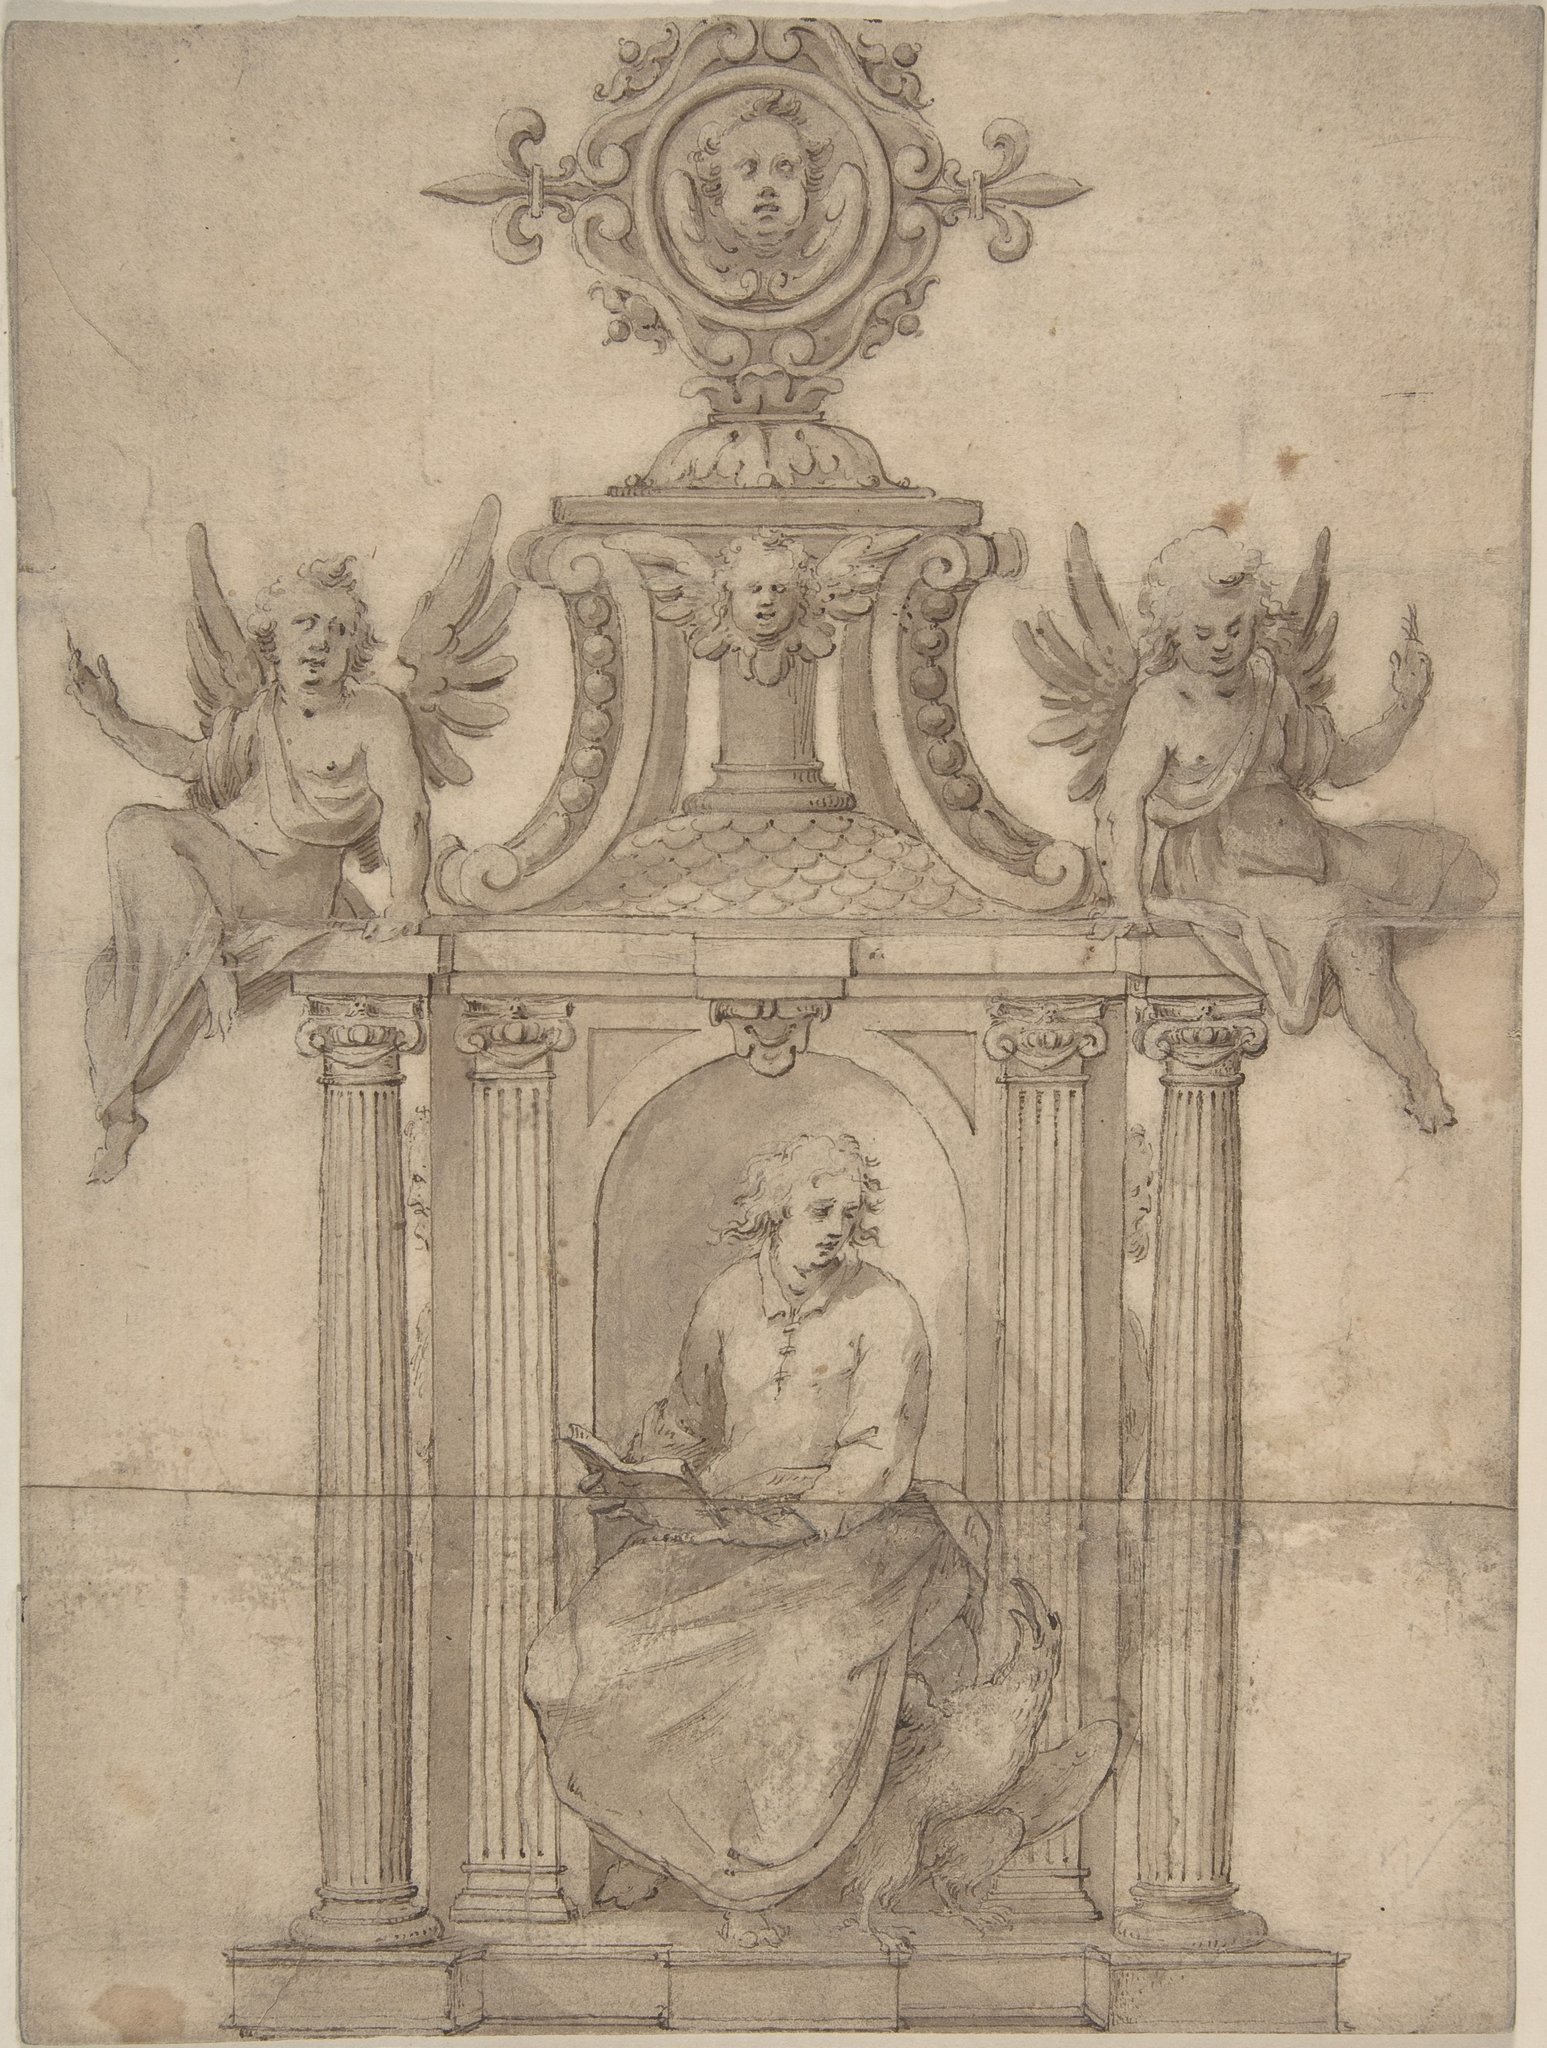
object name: drawing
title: Ornamental Drawing, with St. John the Evangelist Seated in a Columned Niche, with Two Putti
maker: anonymous, italian, late 16th century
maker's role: artist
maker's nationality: italian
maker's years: 1550-1600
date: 1550-1600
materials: ink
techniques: brush, pen, wash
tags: putti,saint john the evangelist